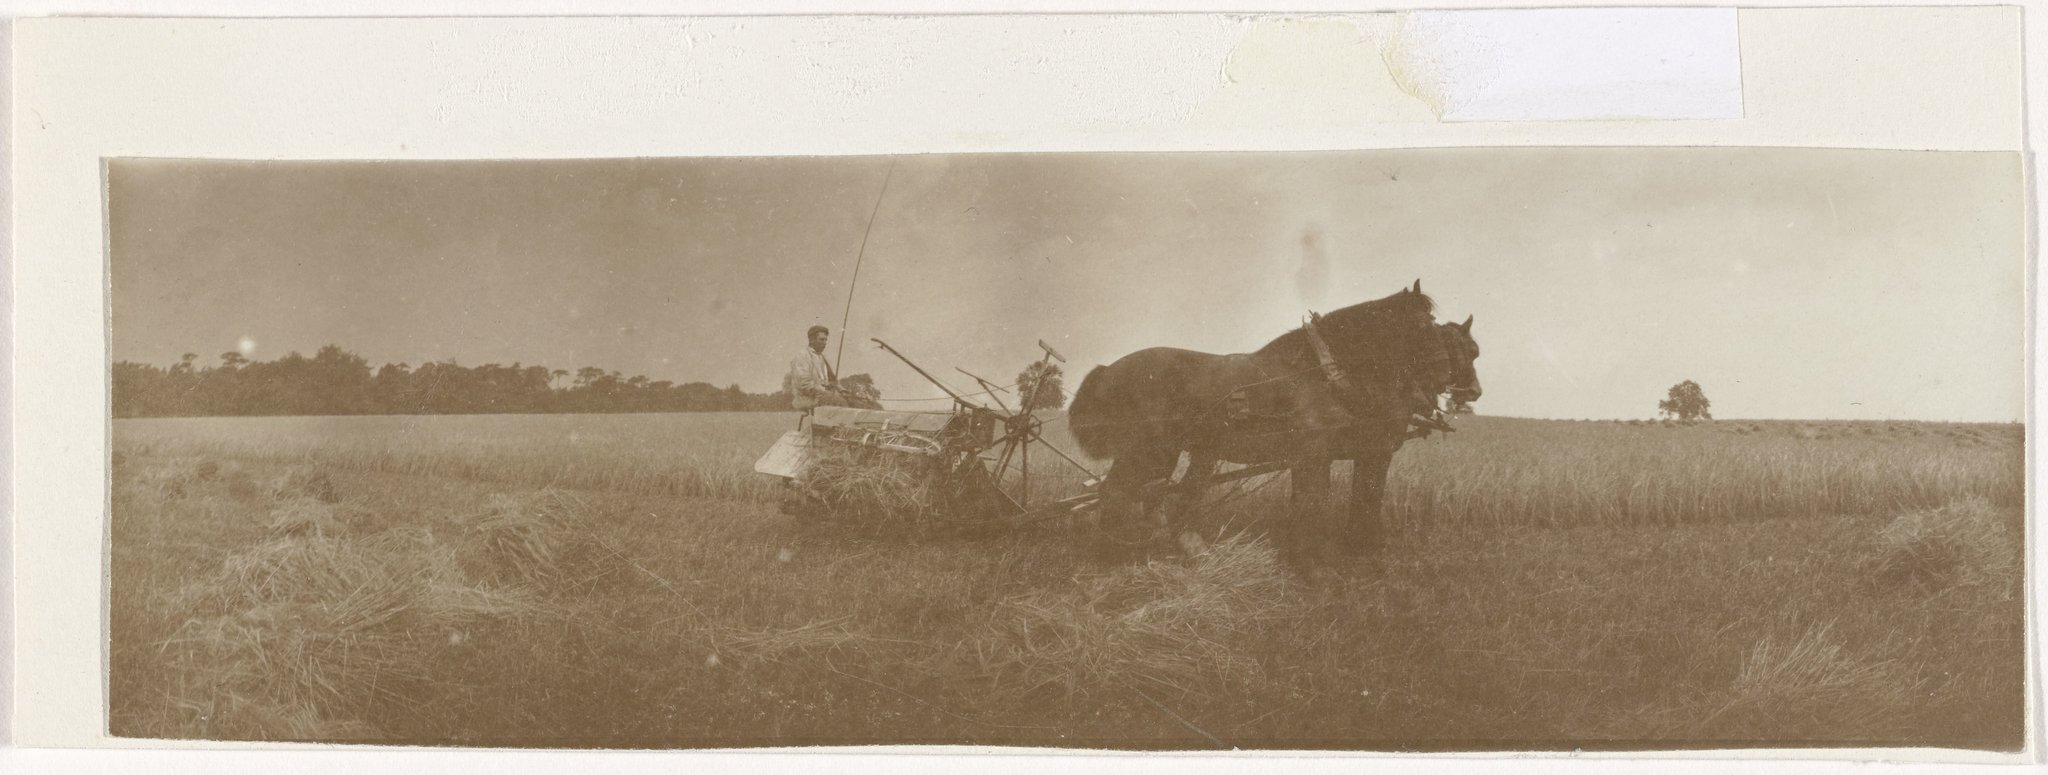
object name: panoramic photograph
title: Boer met ploeg en een span paarden in Groot-Brittannië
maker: Anonymous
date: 1900-1915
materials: paper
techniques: albumen print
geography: great britain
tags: agricultural implements: plough